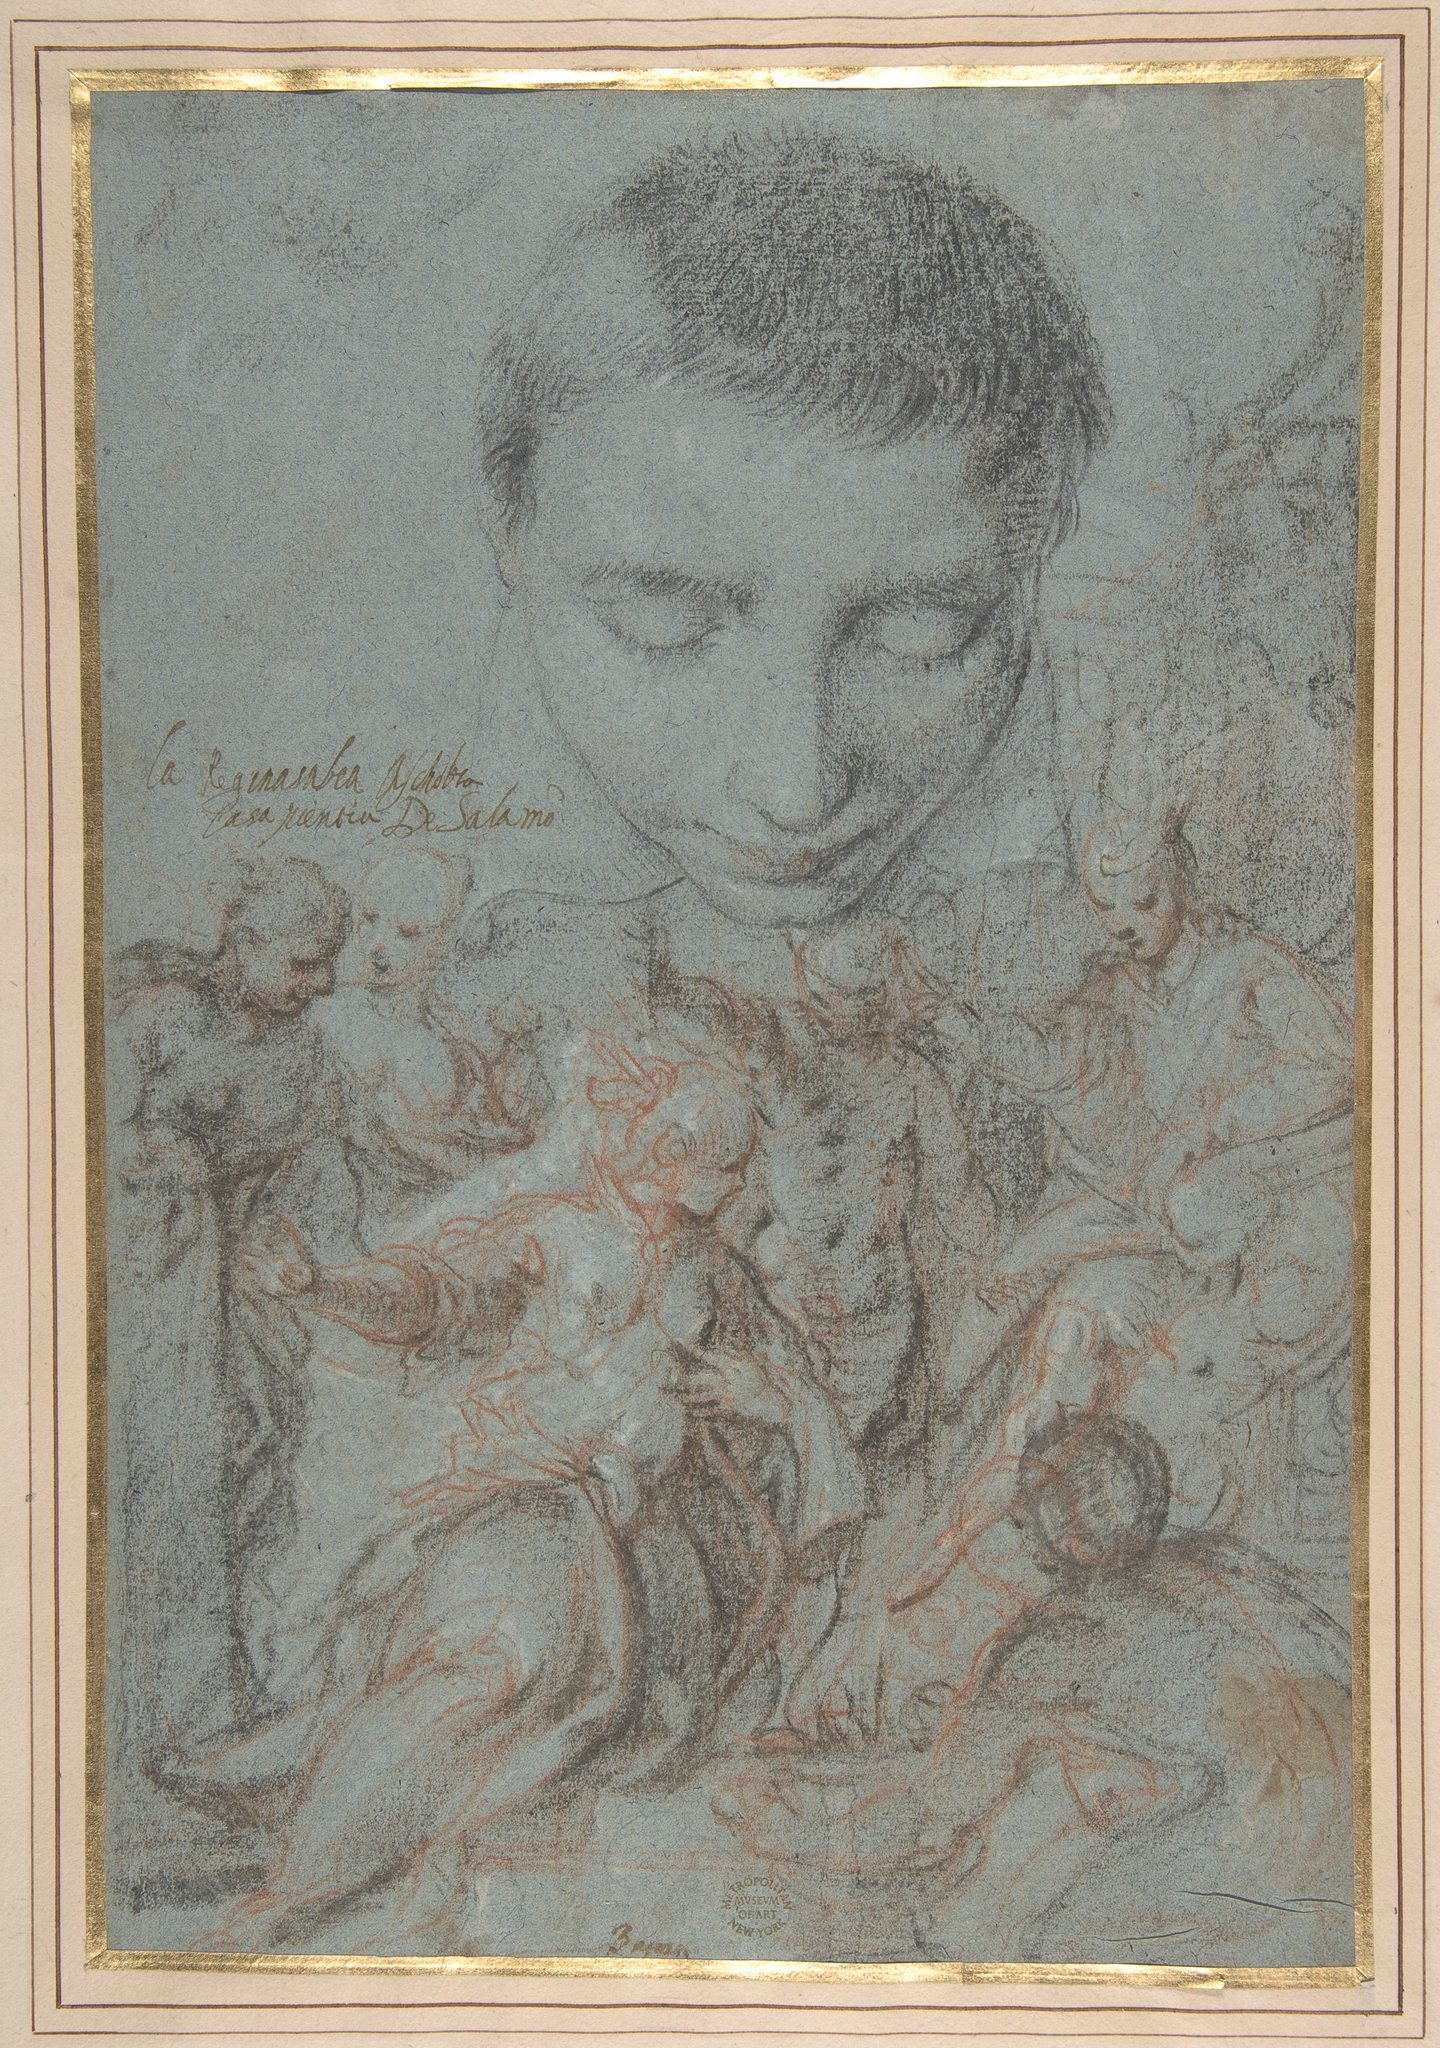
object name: drawing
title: Study of Boy's Head; the Queen of Sheba Before Solomon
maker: antonio vassilacchi (called "il aliense")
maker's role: artist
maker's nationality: italian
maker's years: 1556-1629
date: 1580-1594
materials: chalk, paper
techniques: highlighting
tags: heads,boys